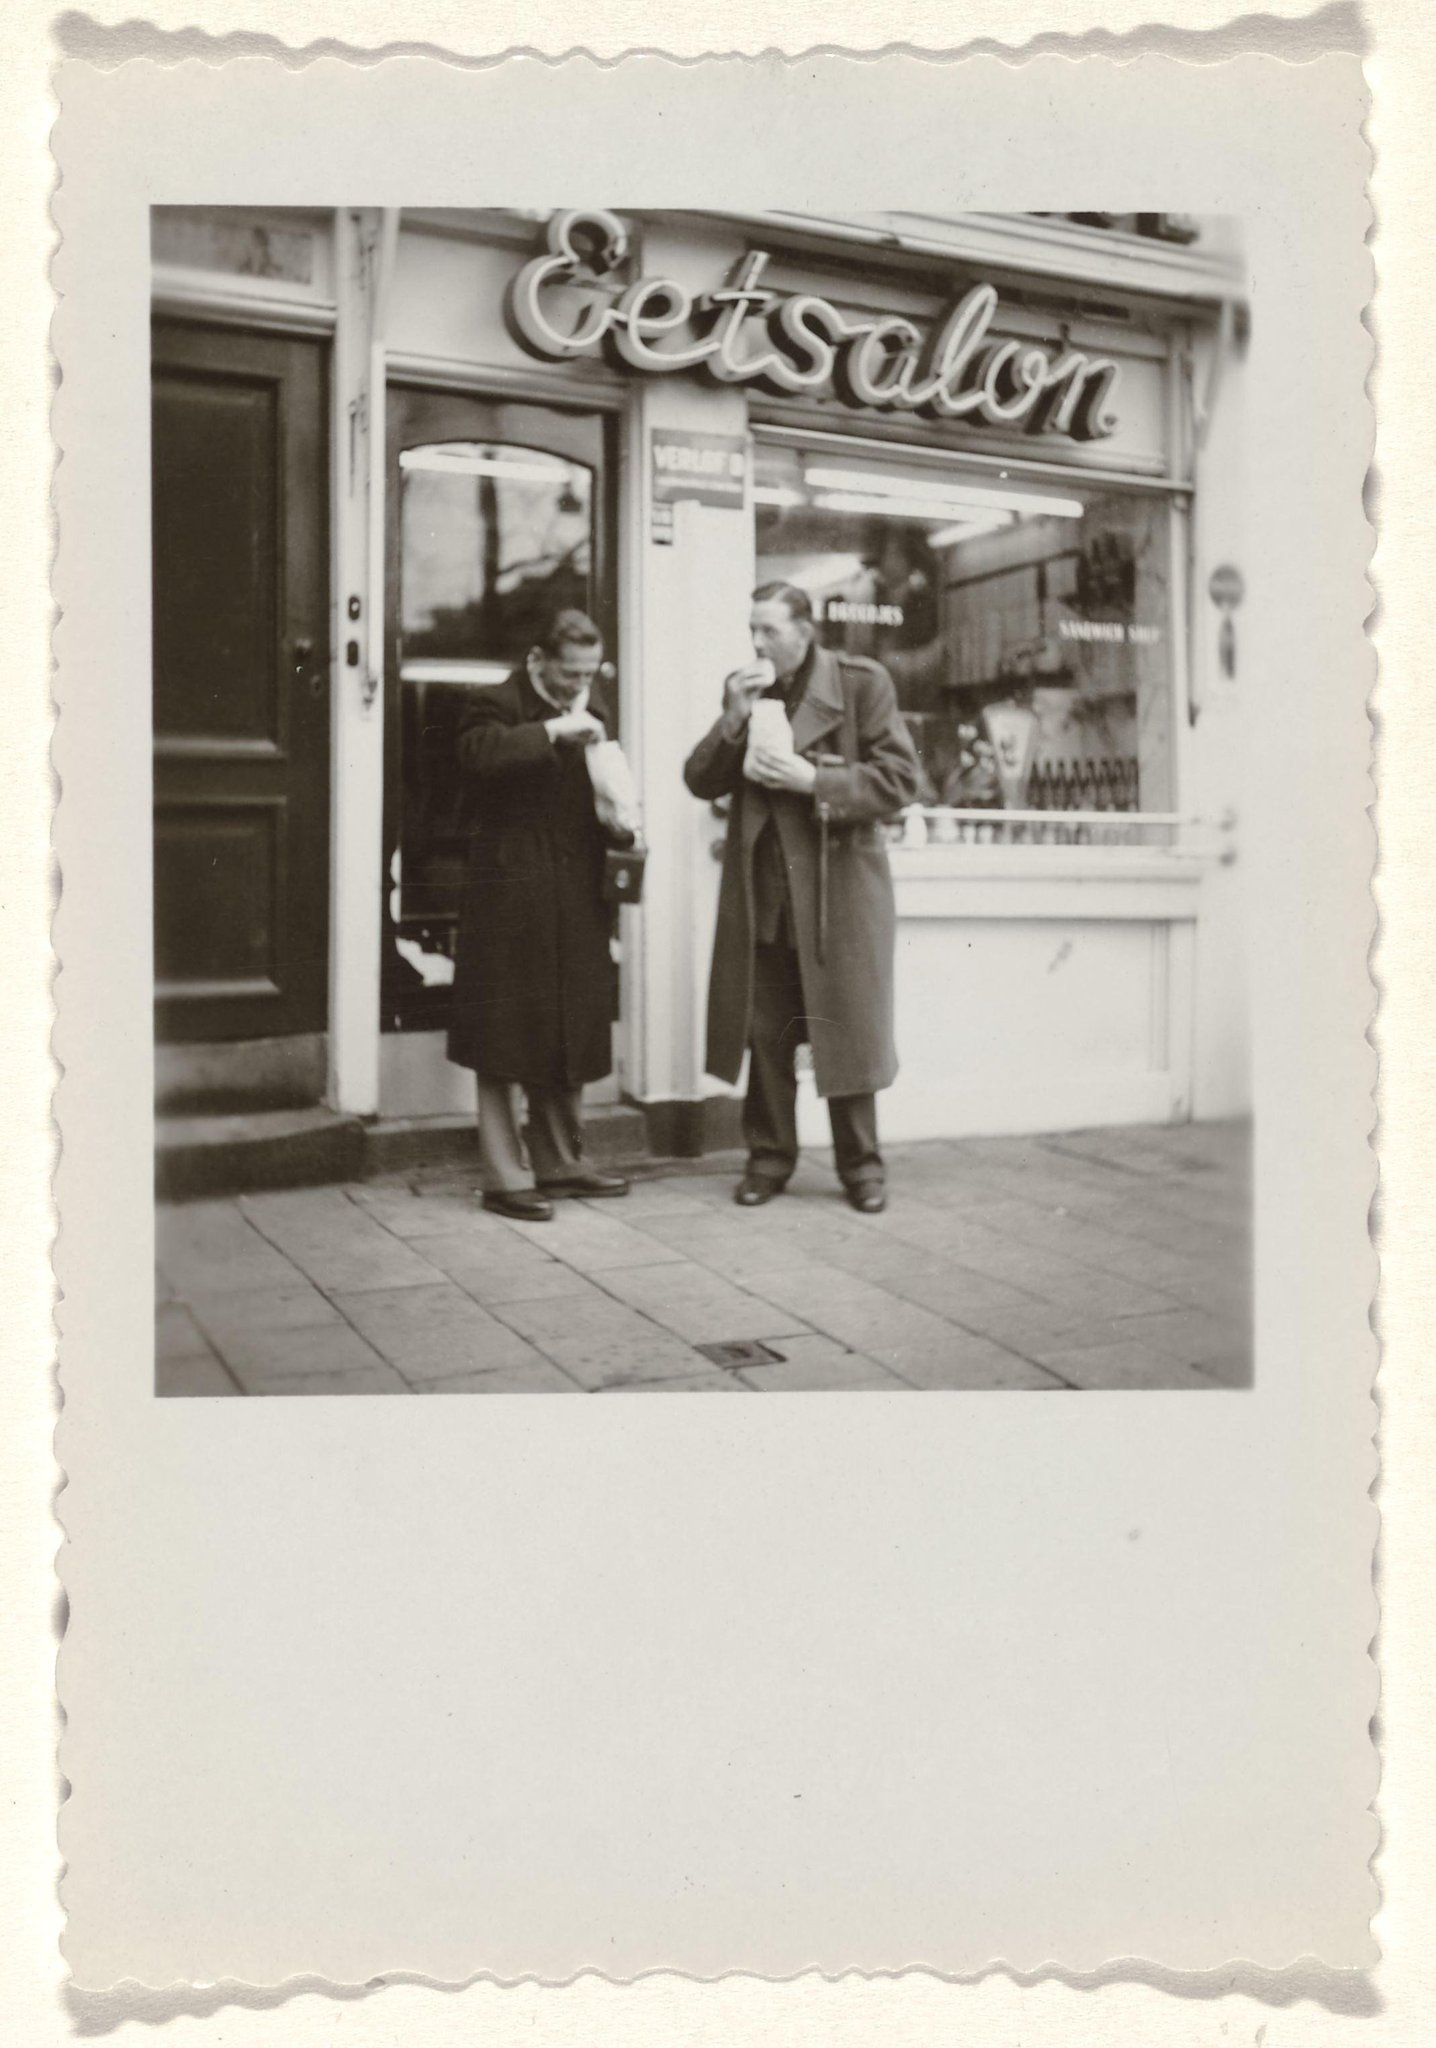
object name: photograph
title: Gideon Elon, de derde echtgenoot van Isabel Wachenheimer, met een onbekende man etende uit een papieren zak voor een Nederlandse eetsalon met opschrift Eetsalon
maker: Anonymous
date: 1956-1970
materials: photographic support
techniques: gelatin silver print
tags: gideon elon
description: Gideon Elon (links), de derde echtgenoot van Isabel Wachenheimer, met een onbekende man etende uit een papieren zak voor een Nederlandse eetsalon met opschrift Eetsalon